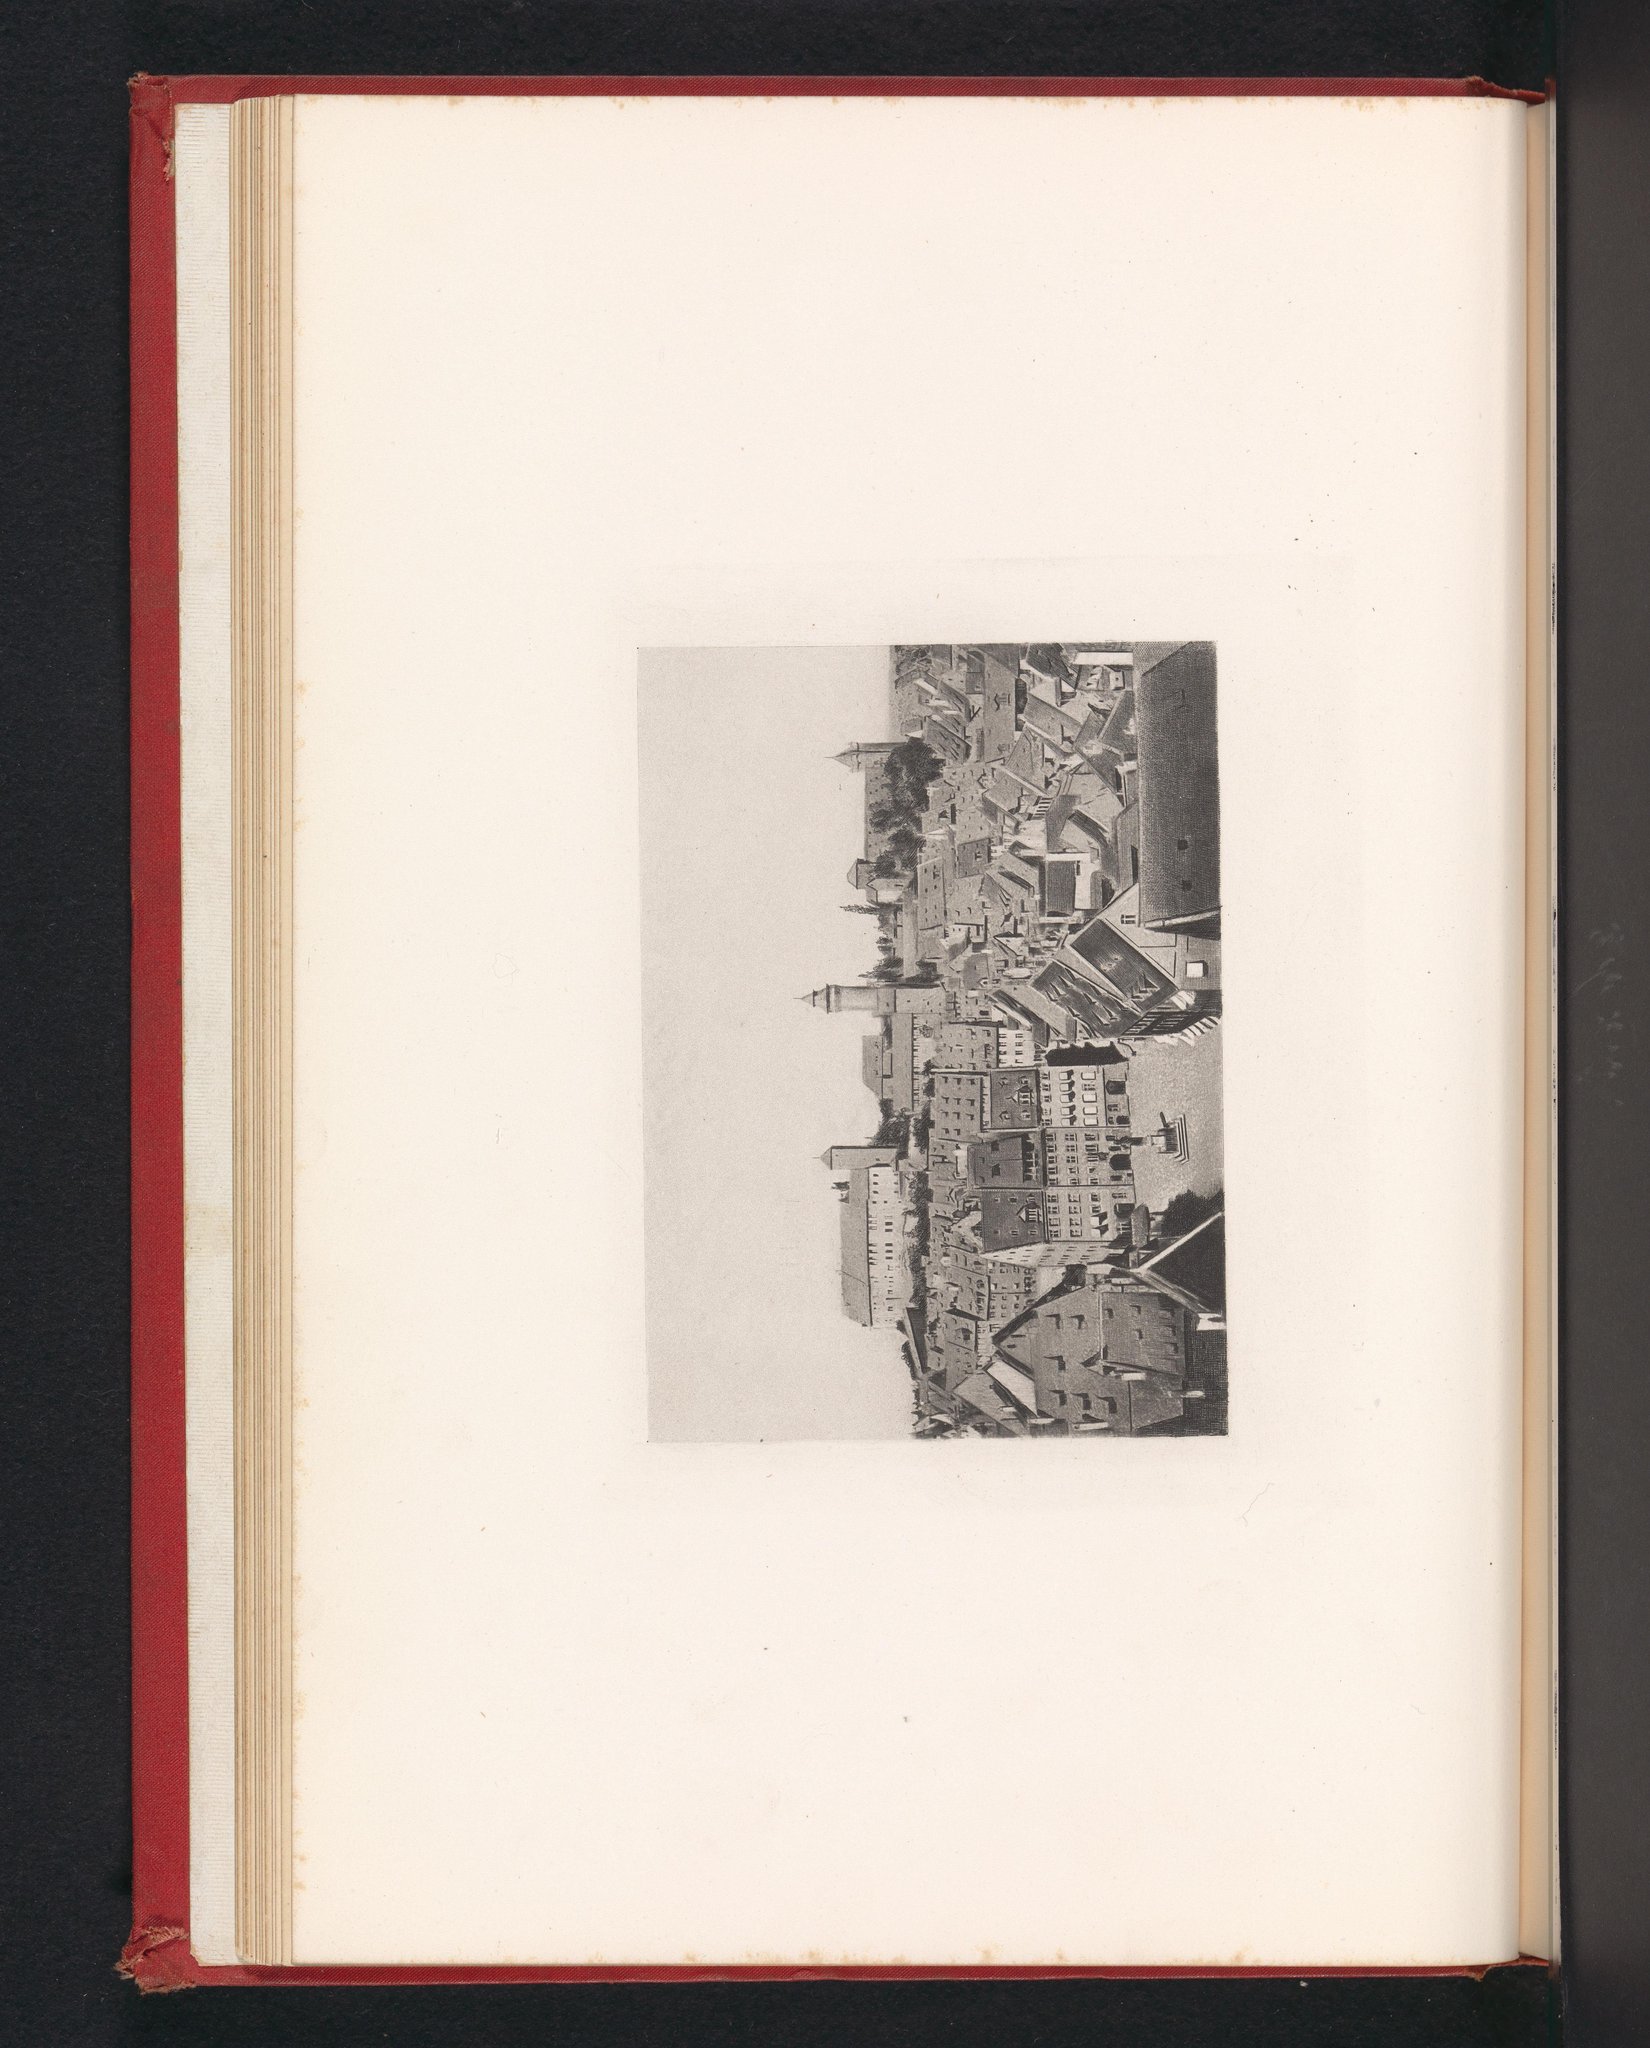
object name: page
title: Fotoreproductie van een prent van een gezicht op het Albrecht-Dürer-Platz en Kasteel Neurenberg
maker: Anonymous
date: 1878-1888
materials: paper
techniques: photoaquatint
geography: philadelphia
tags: square, place, circus, etc., city-view, and landscape with man-made constructions, castle